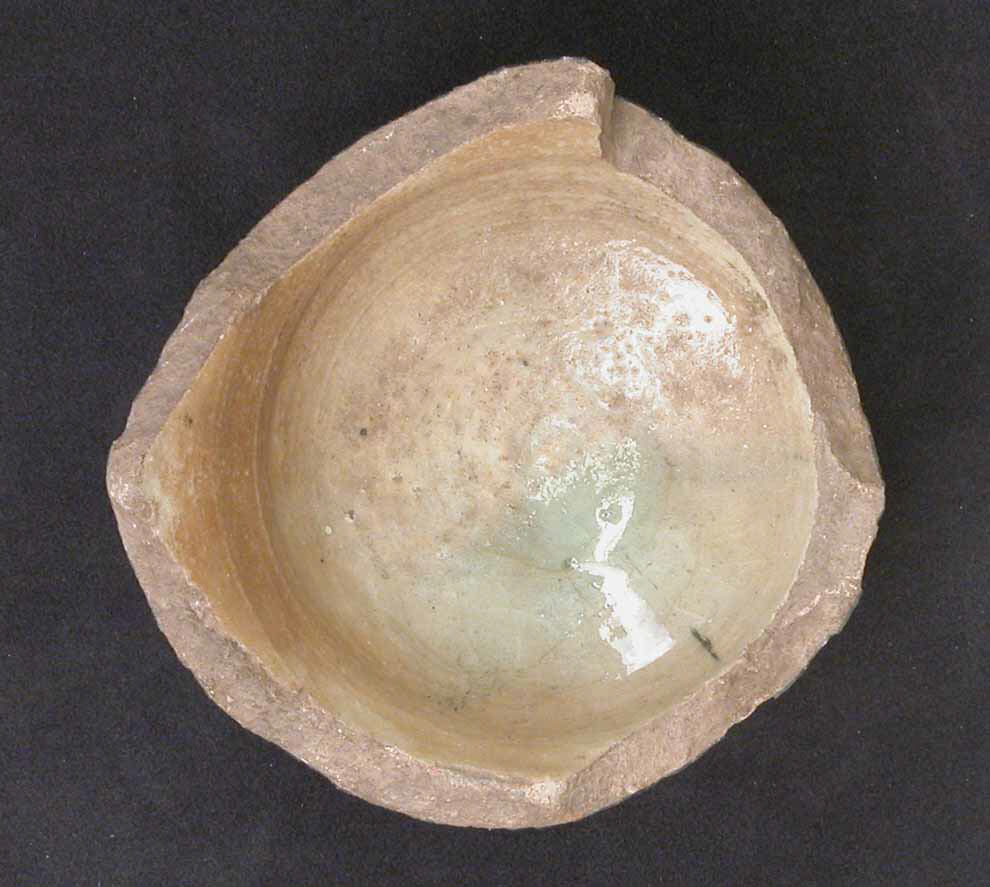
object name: fragment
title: Ceramic Fragment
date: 1301-1400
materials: glaze, stonepaste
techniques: painting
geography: syria